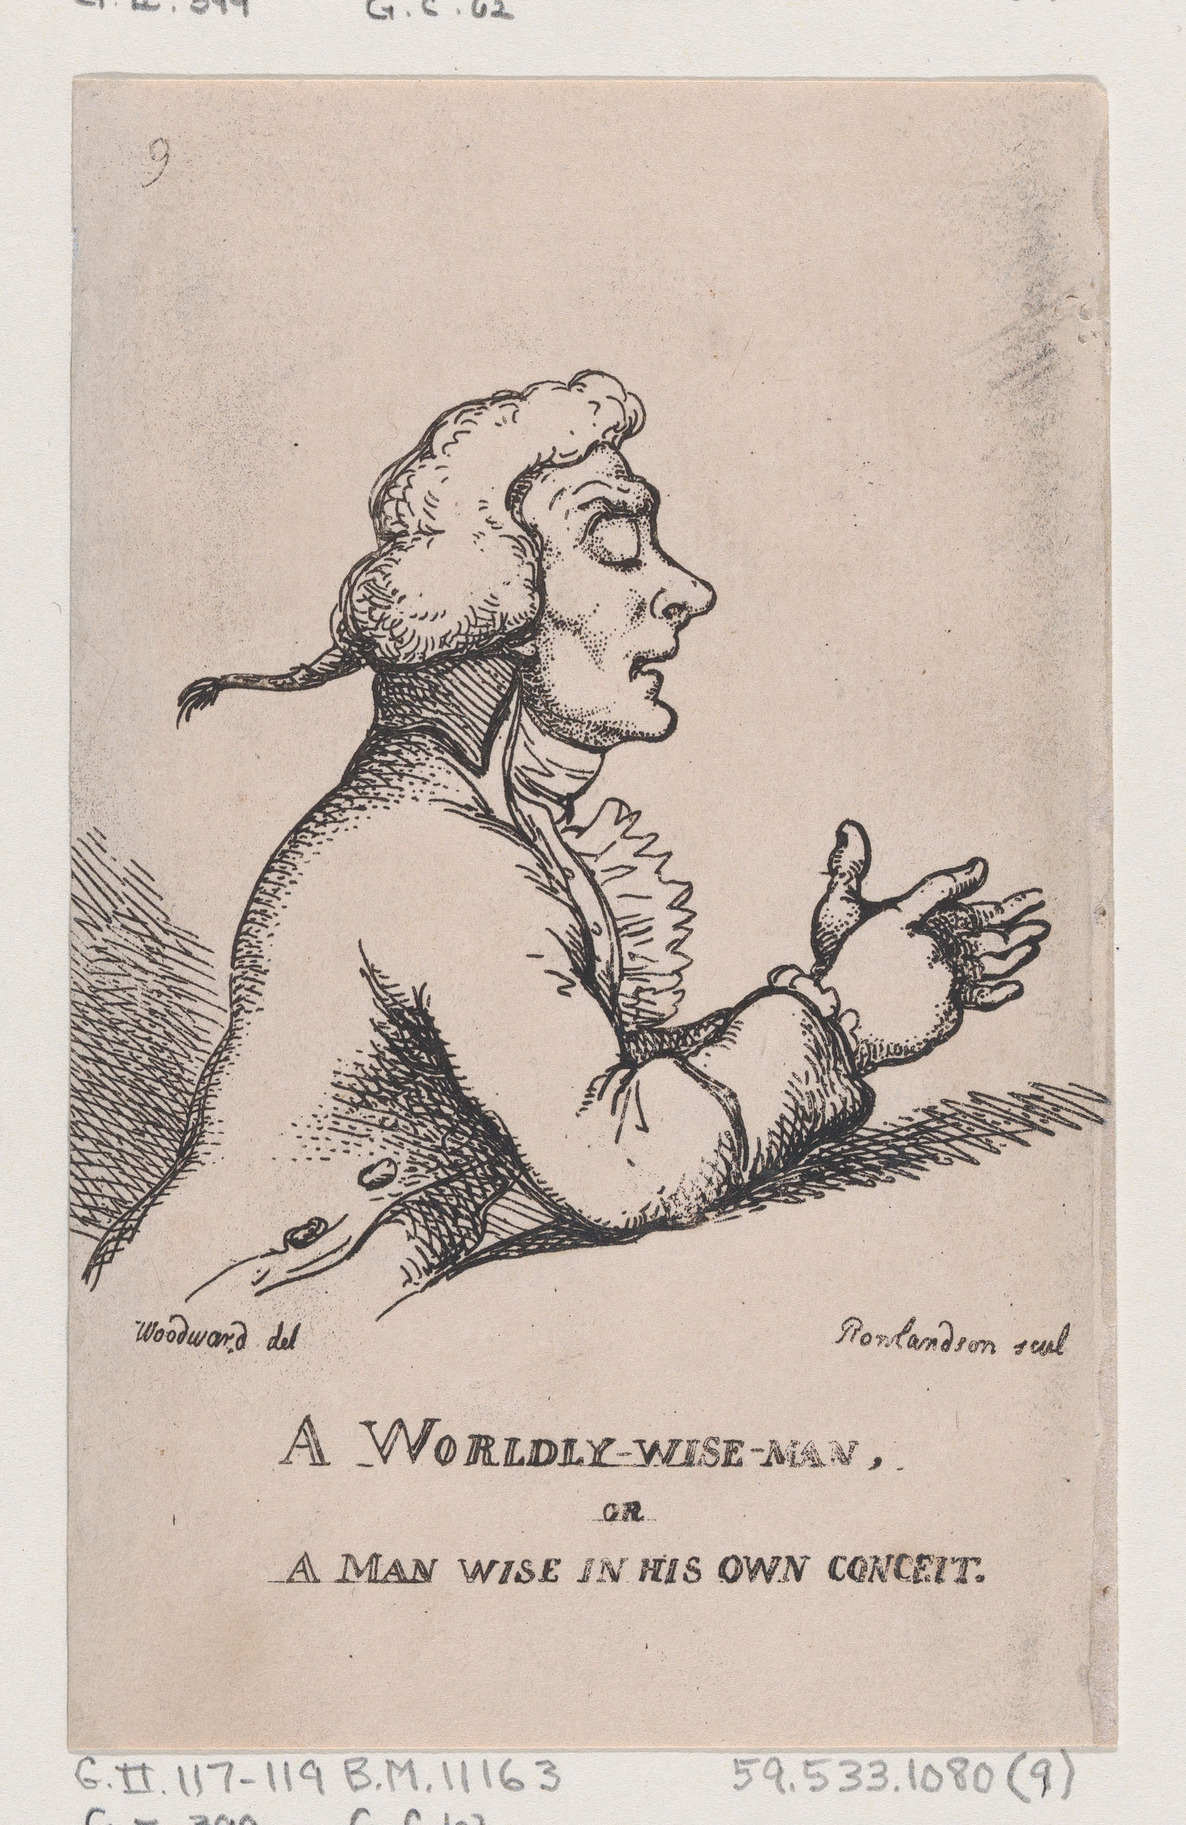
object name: print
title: A Worldly-Wise Man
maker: thomas rowlandson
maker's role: artist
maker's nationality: british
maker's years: 1757-1827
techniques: etching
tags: men,profiles